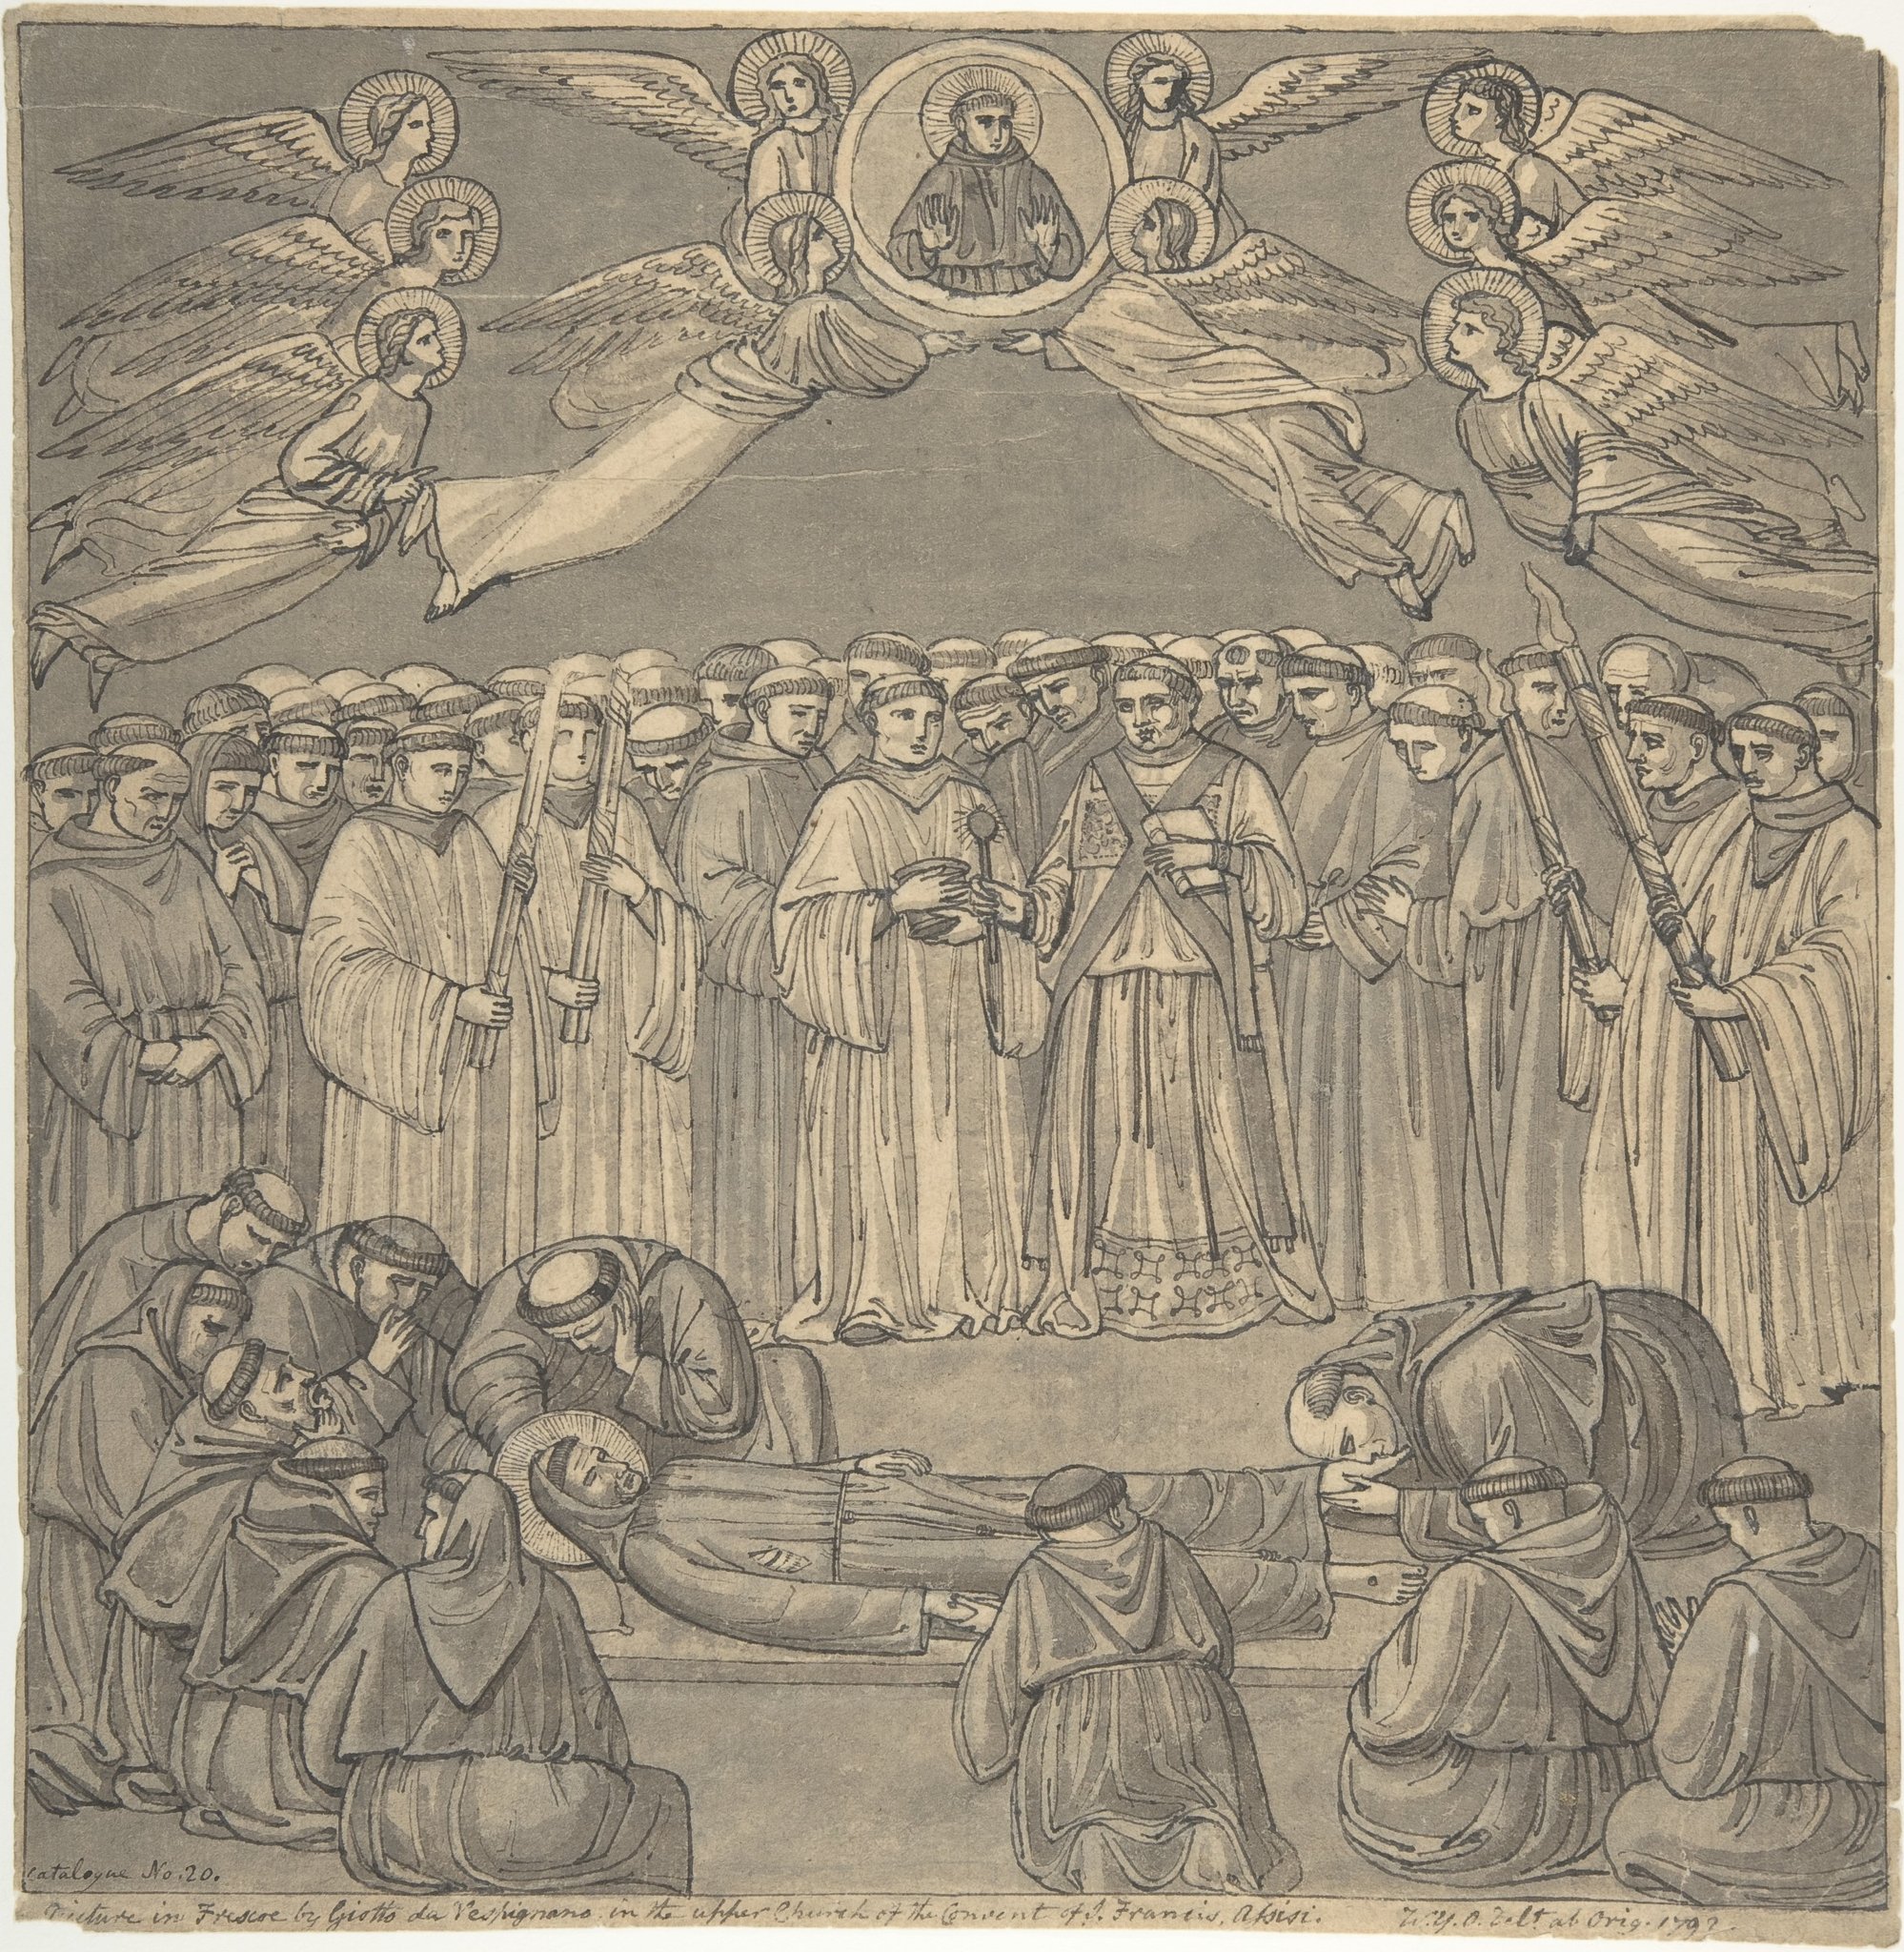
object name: drawing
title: Death of St. Francis, after Giotto, upper Church San Francesco, Assisi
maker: william young ottley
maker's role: artist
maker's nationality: british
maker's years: 1771-1836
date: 1795-1836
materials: ink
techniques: brush, pen, wash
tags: men,angels,saint francis,saints,death